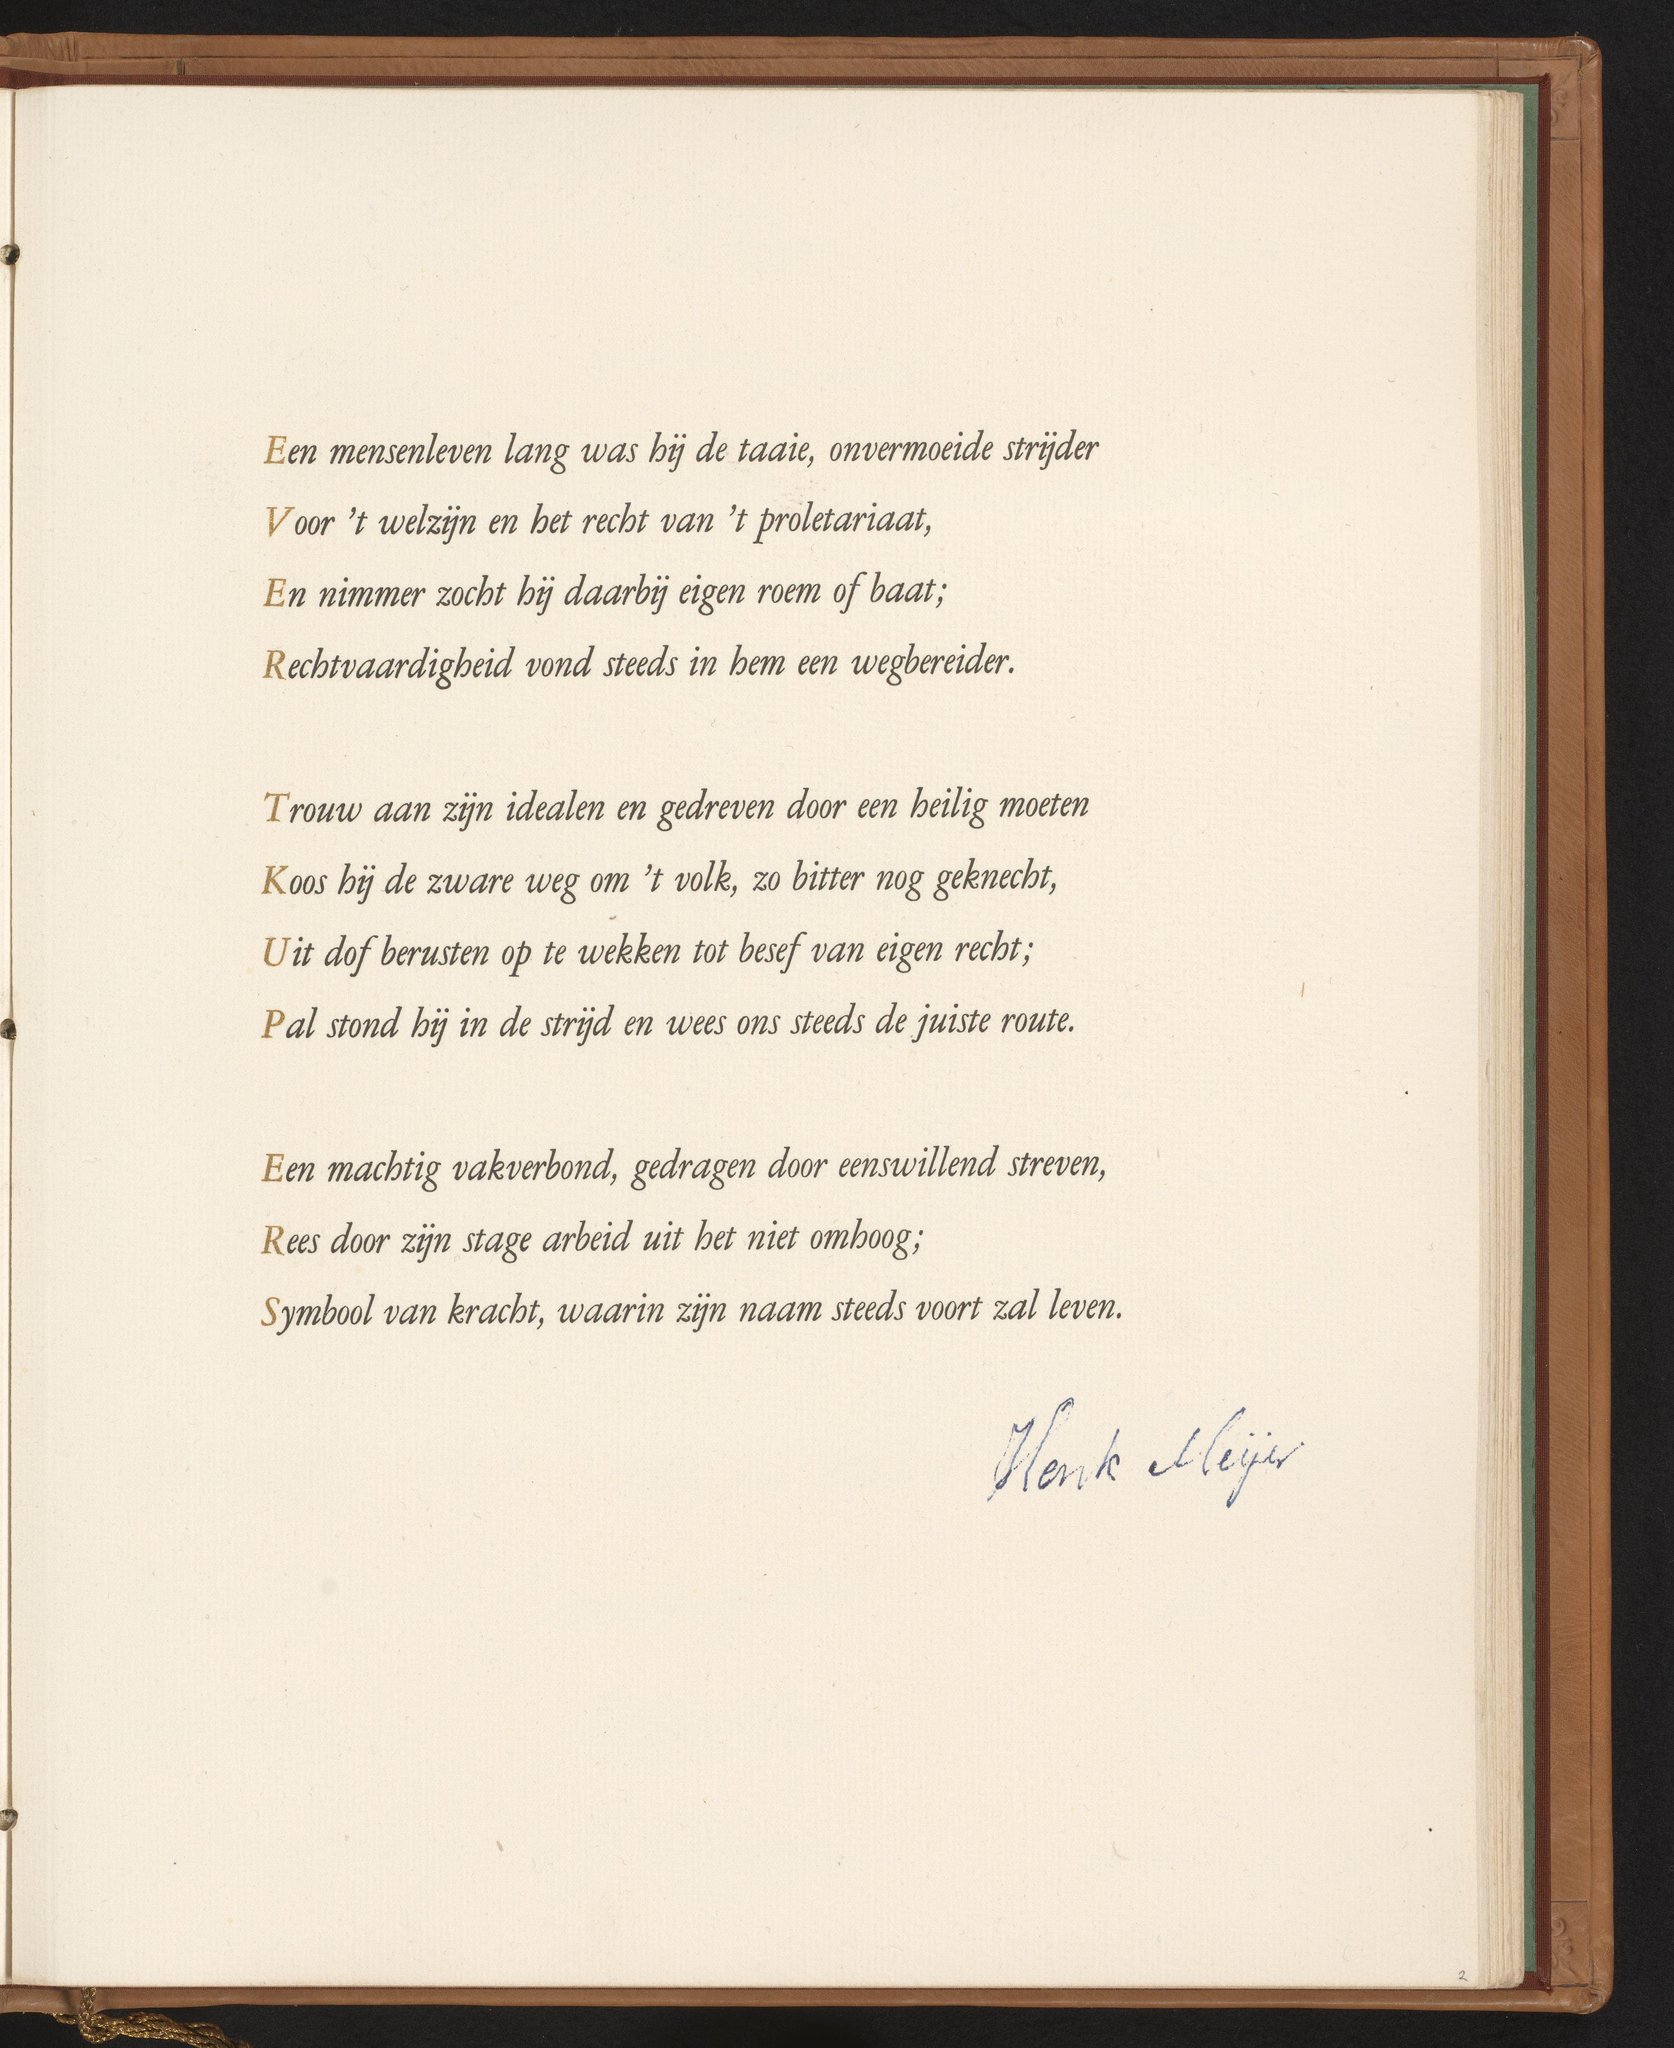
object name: album leaf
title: Acrostichon met de naam van Evert Kupers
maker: henk romijn meijer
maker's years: 1929-2008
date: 1949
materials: paper, ink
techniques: printing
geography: netherlands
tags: modern professional organization, trade union, reception, cocktail party, amsterdam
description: Acrostichon met de naam van Evert Kupers, gesigneerd door Henk Meijer. Onderdeel van het fotoalbum ter gelegenheid van het afscheid van Evert Kupers als voorzitter van de NVV op 14 juli 1949 in Amsterdam.